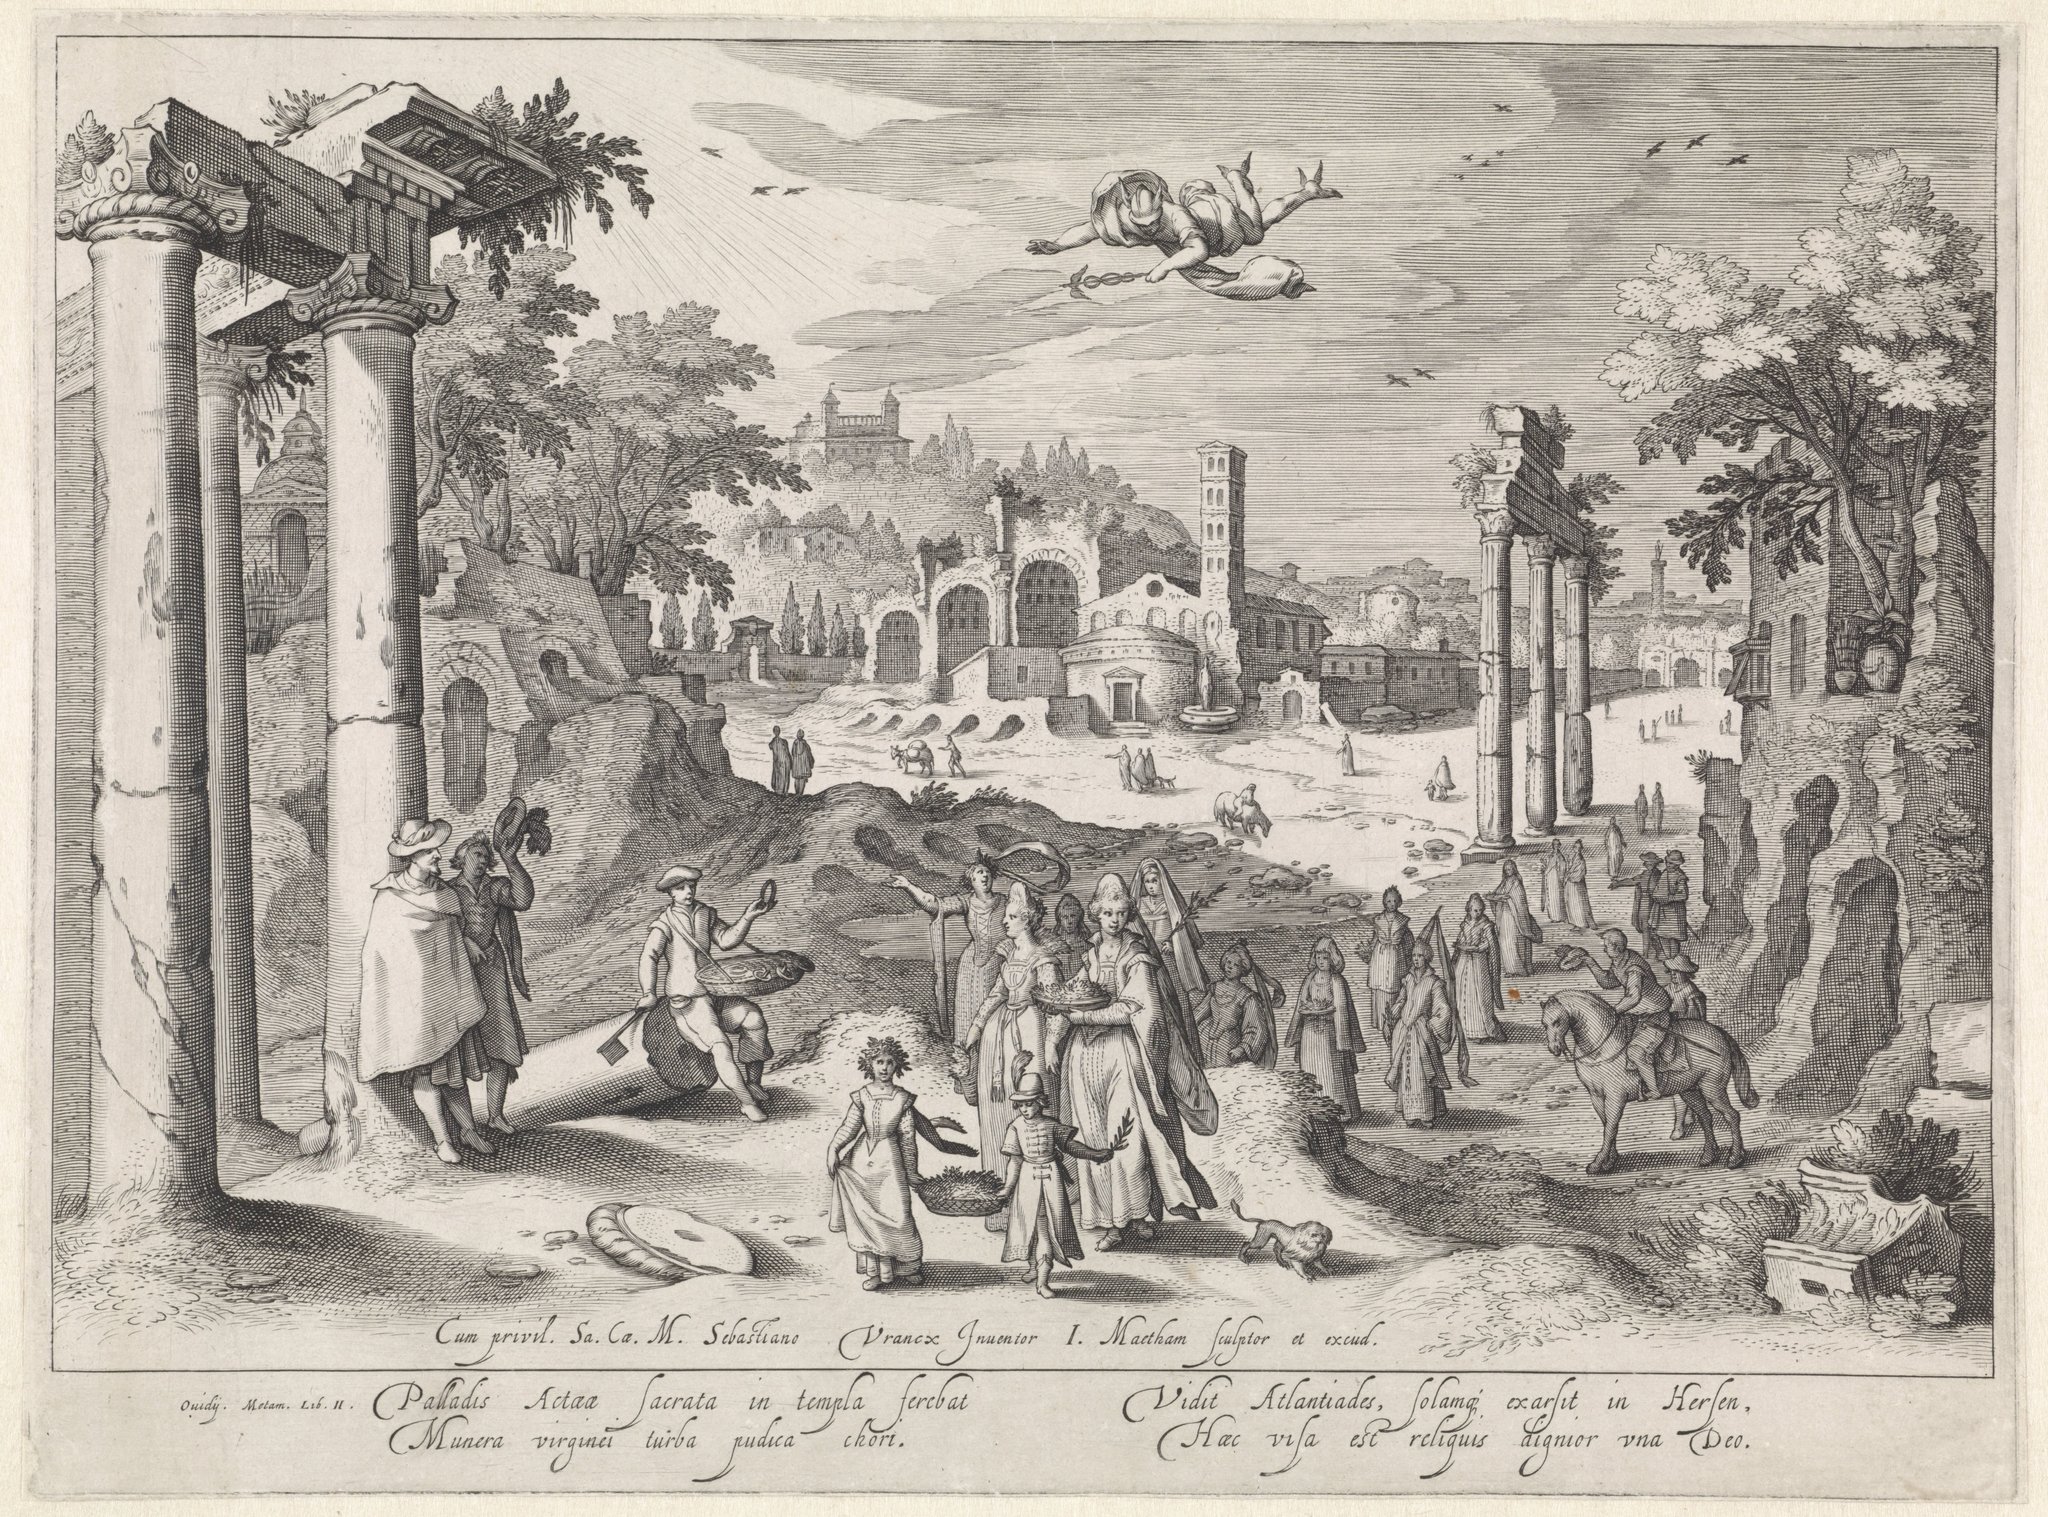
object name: print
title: Mercurius en Herse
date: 1604-1608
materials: paper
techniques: engraving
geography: haarlem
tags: mercury falls in love with herse, when seeing her and her companions carry baskets full of flowers to the temple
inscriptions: collector's mark: Lugt 240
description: De in de lucht vliegende Mercurius, met caduceus en gevleugelde schoenen, wordt verliefd op Herse, die met haar zussen en haar gevolg bloemen draagt na terugkeer van een feest van Minerva.